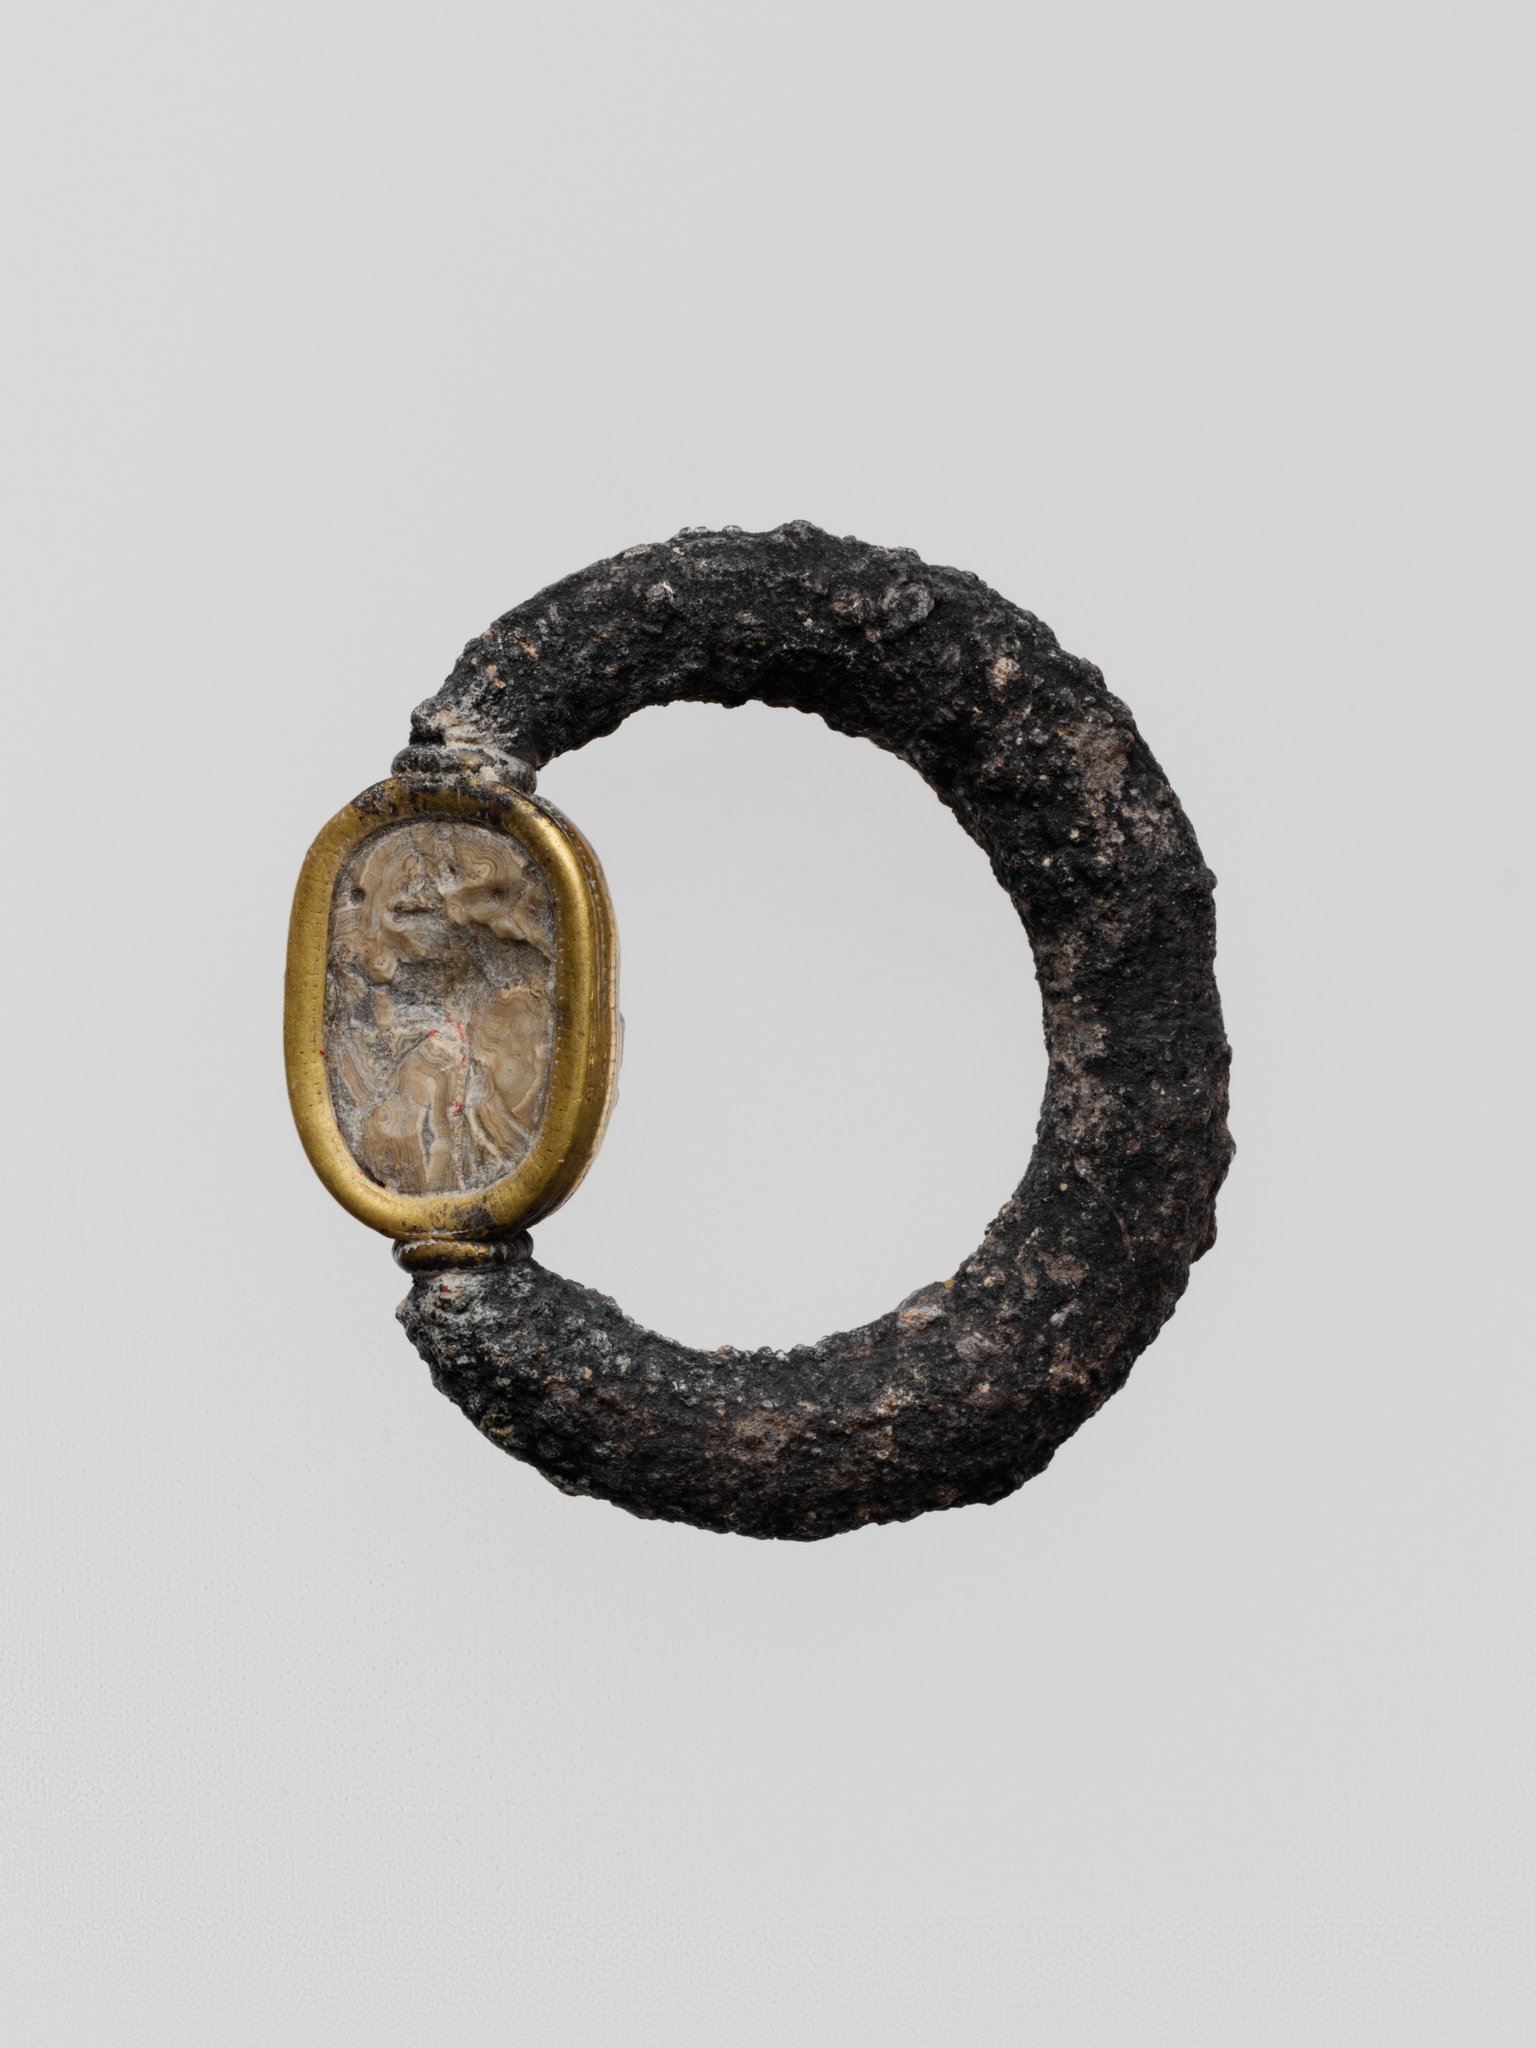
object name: ring with scarab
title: Silver swivel ring with agate scarab in gold setting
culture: cypriot or phoenician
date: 700-468 BCE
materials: stone, silver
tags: scarabs